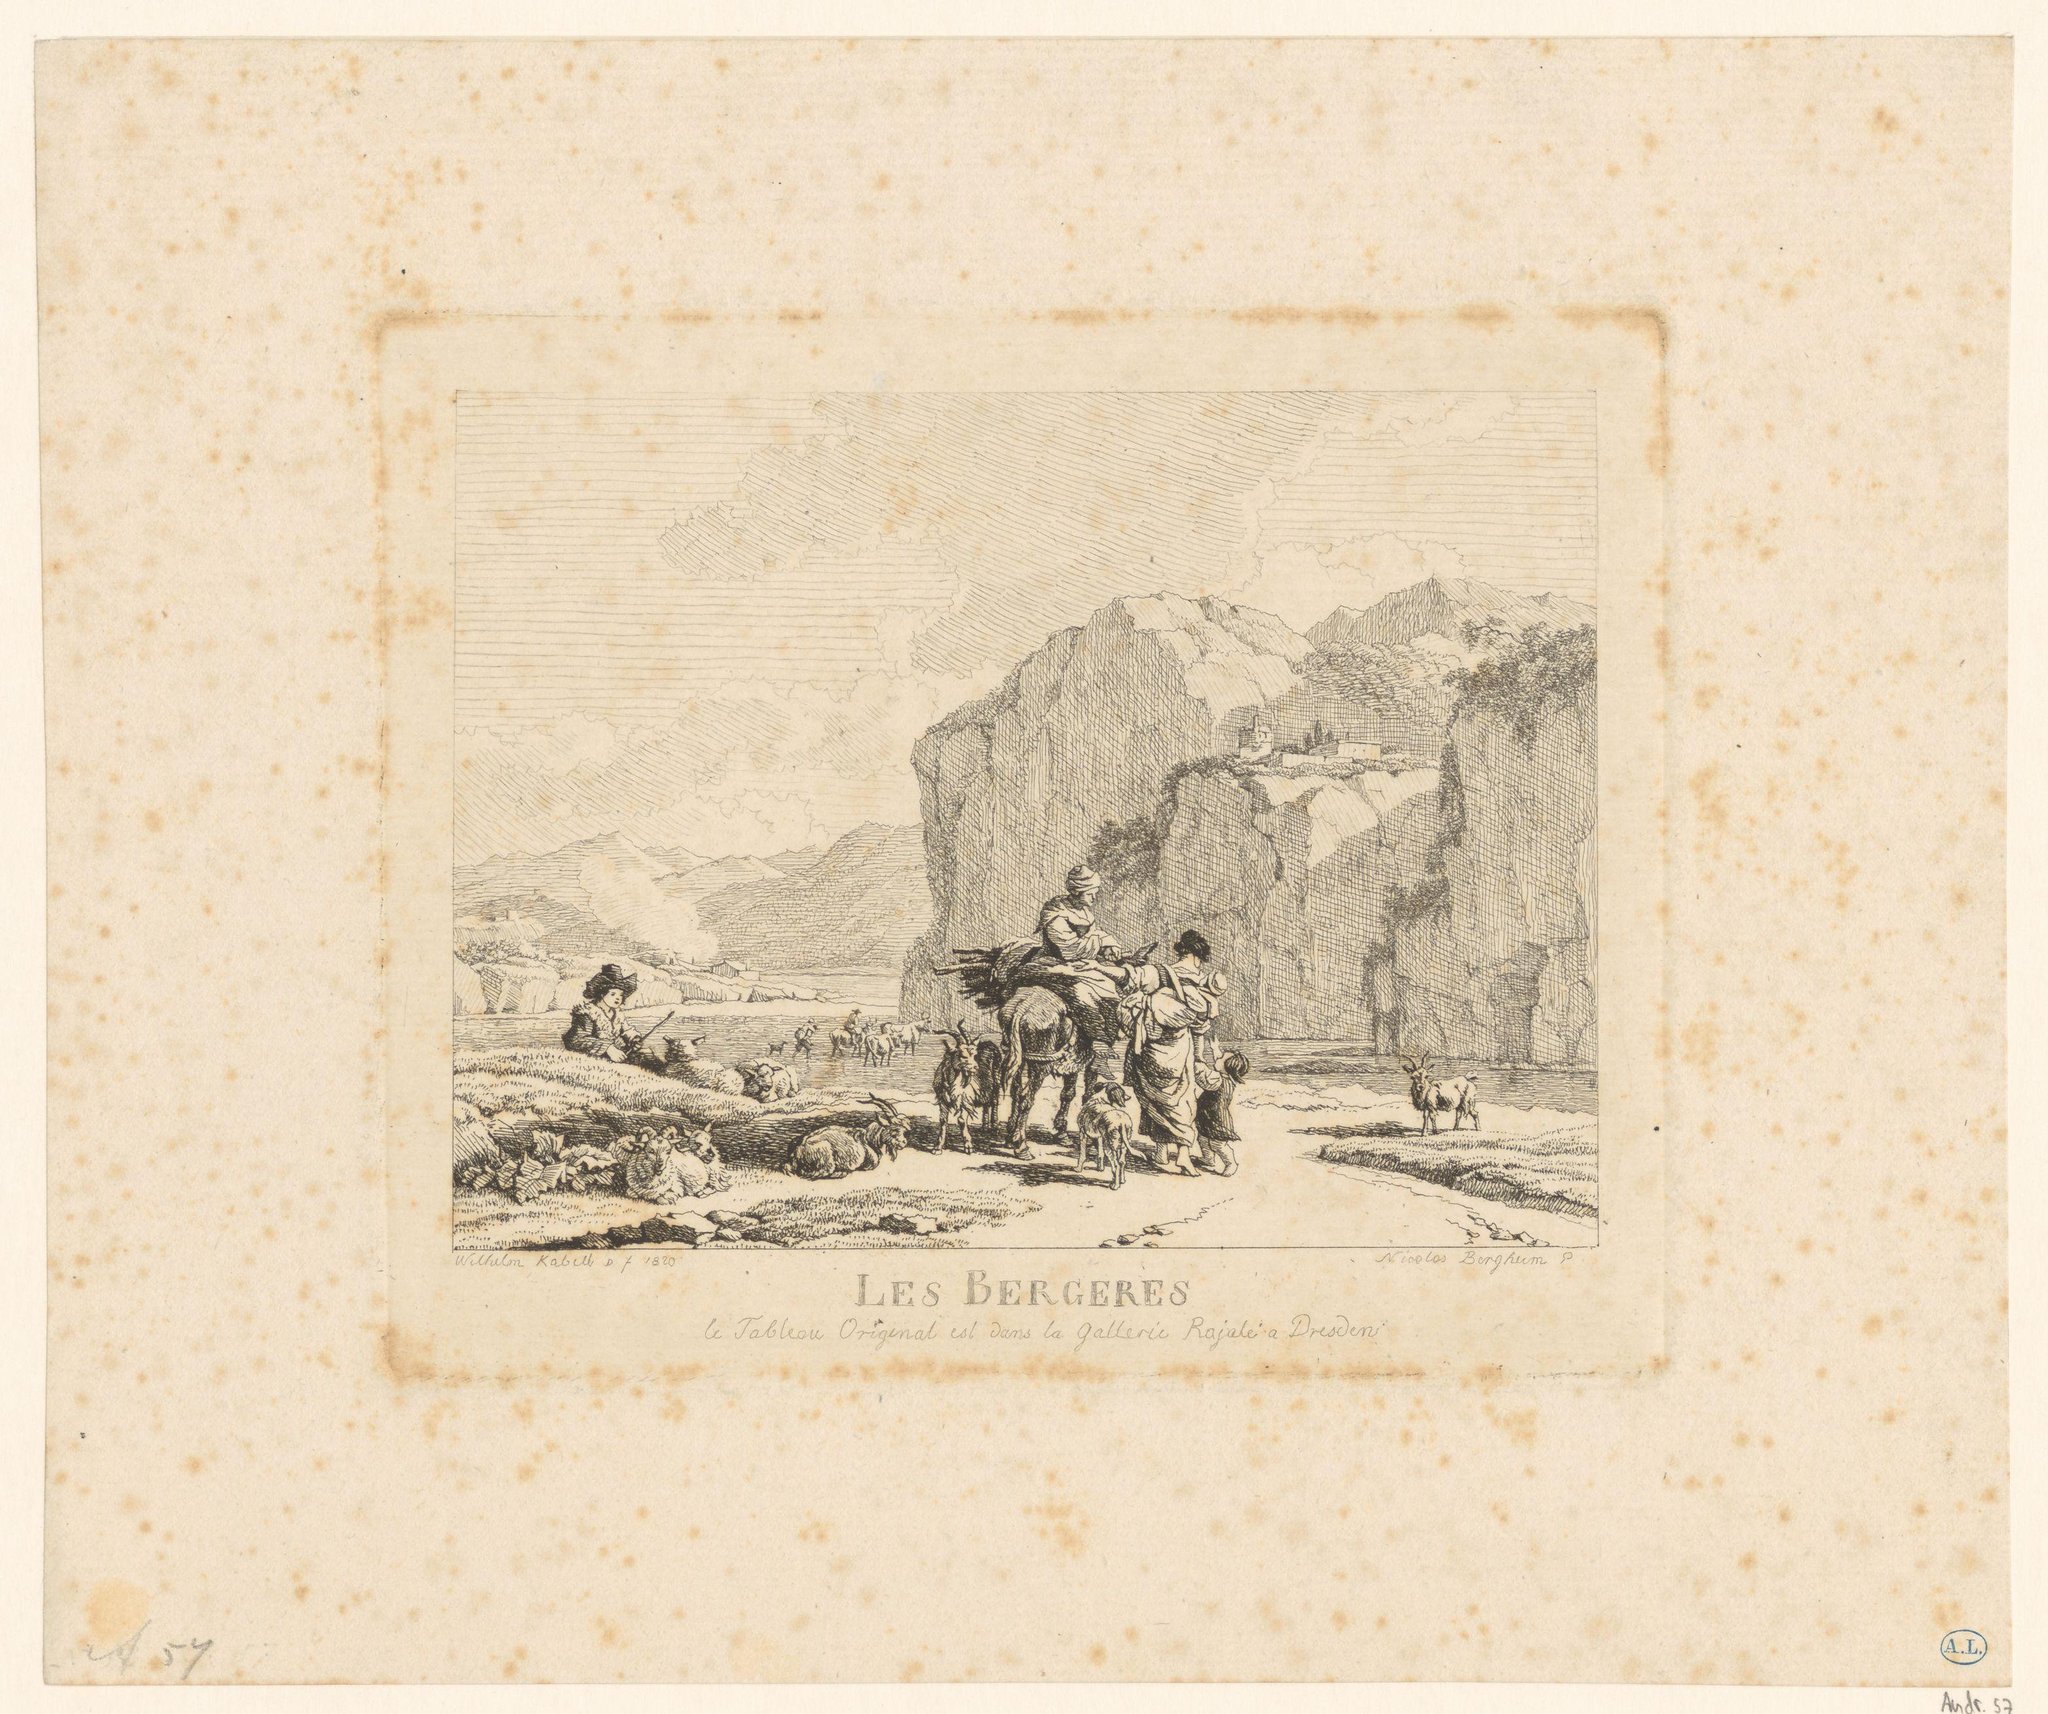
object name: print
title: Les Bergerès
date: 1820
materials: paper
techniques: etching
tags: herding, herdsman, herdswoman, shepherd, shepherdess, cowherd, etc., river bank, mountains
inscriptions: collector's mark: Lugt 3979, collector's mark: Lugt 2228